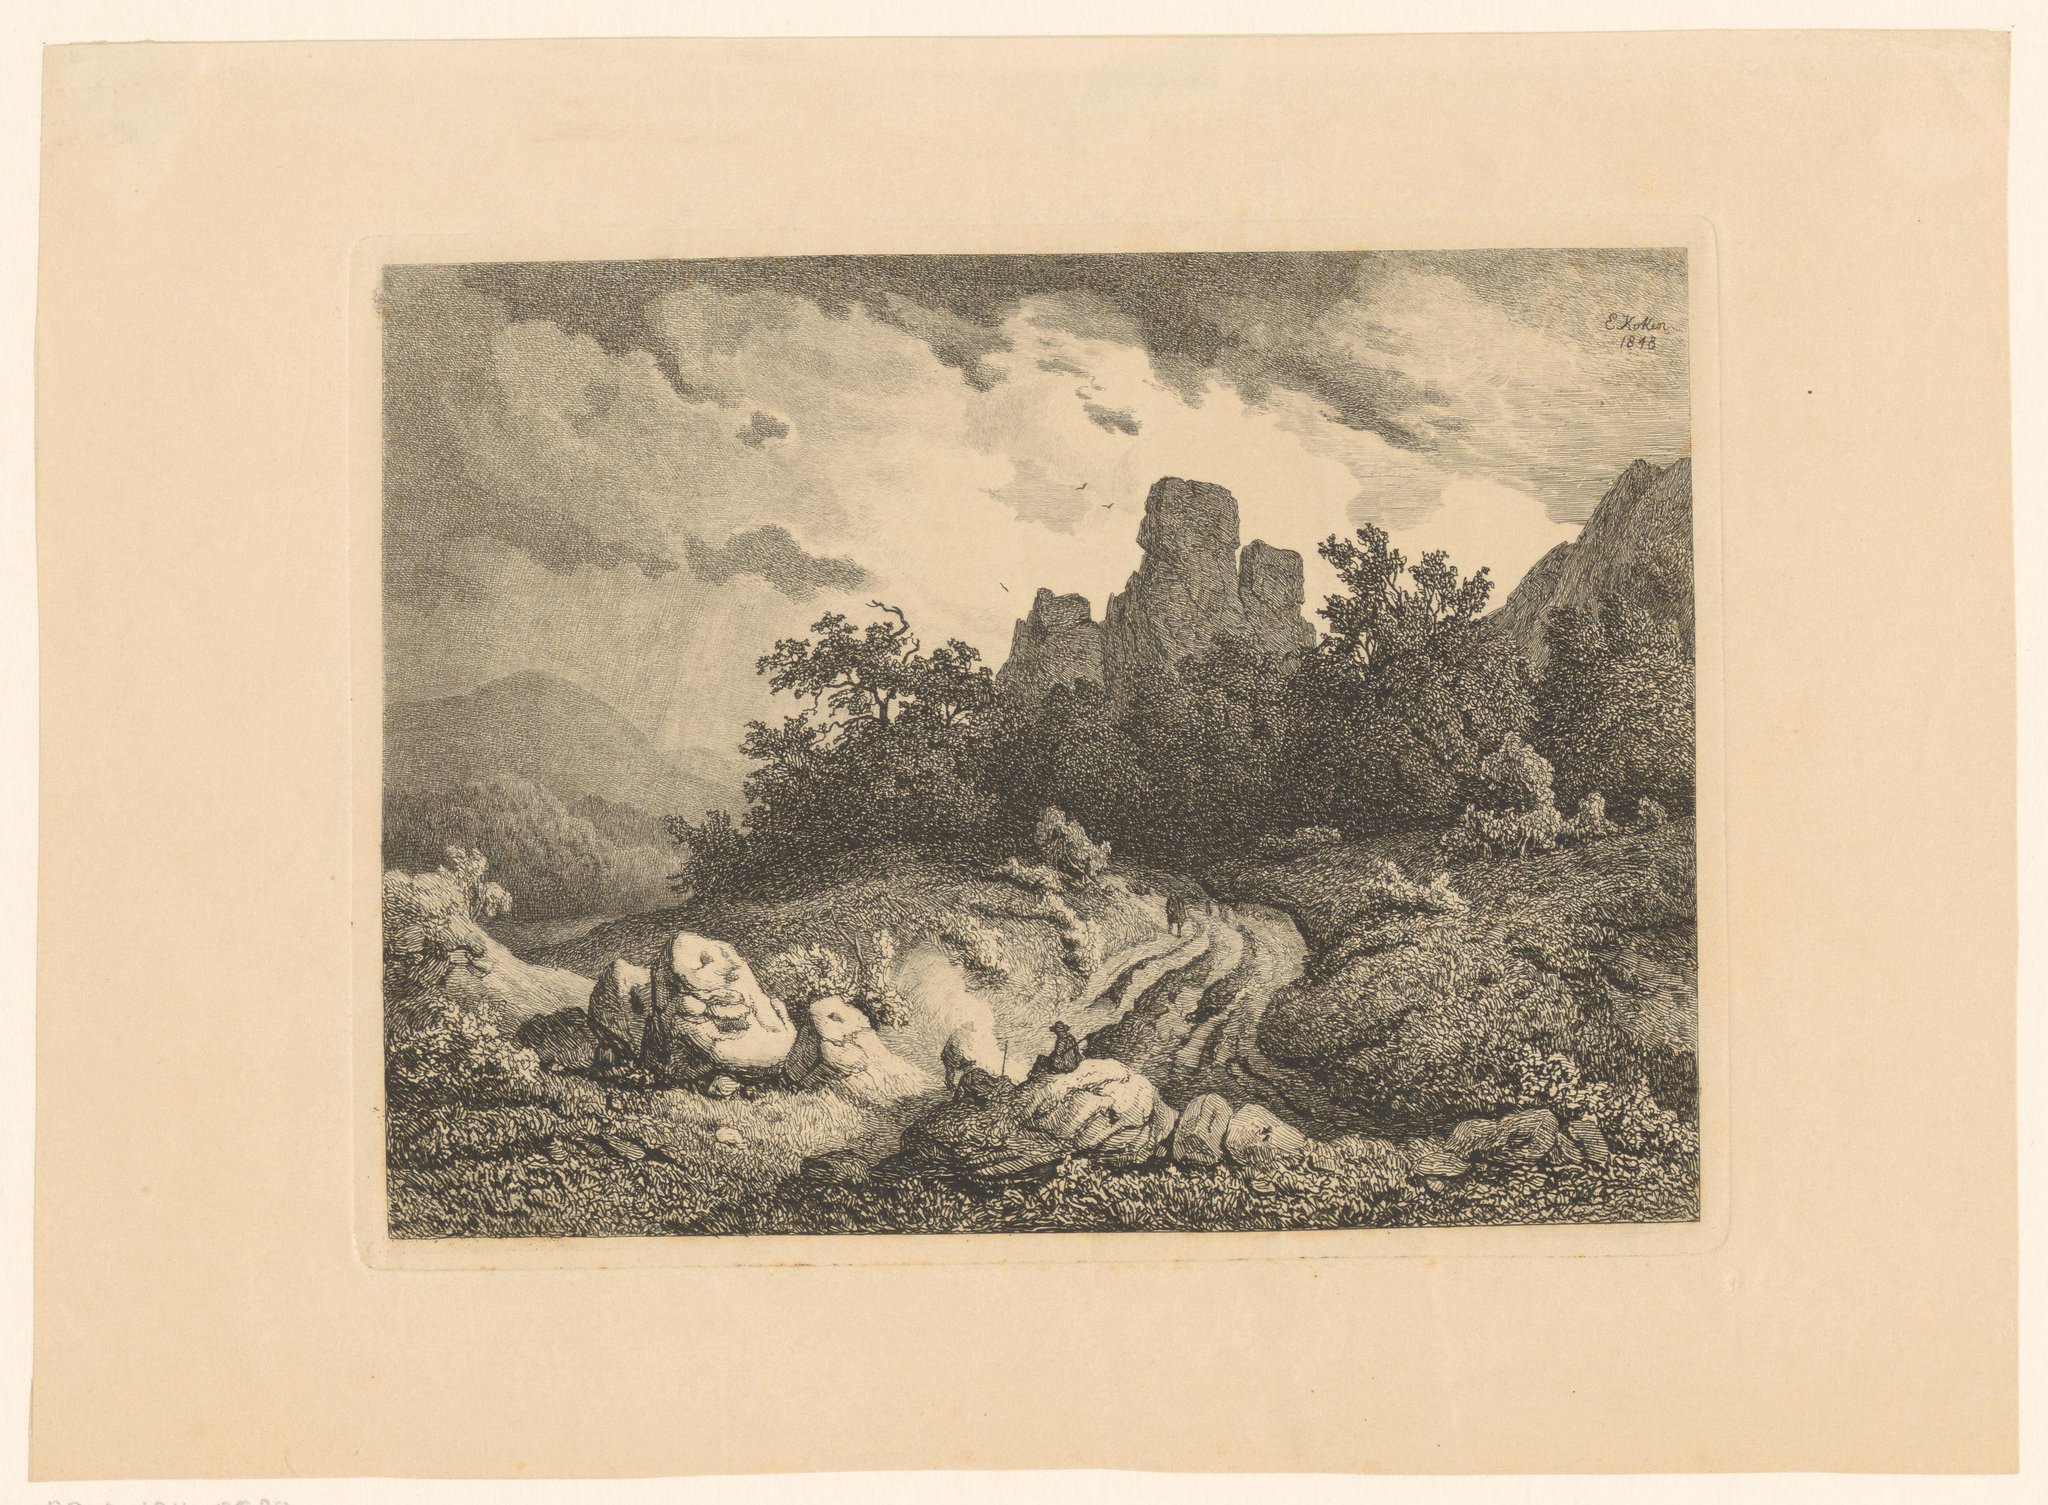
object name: print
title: Rotsachtig landschap met regen op komst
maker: edmund koken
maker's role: painter, print maker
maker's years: 1814-1872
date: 1848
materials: paper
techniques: engraving, etching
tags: downpour, rain shower, (traveller) resting in the open air, (high) hill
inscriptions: collector's mark: Lugt 2228